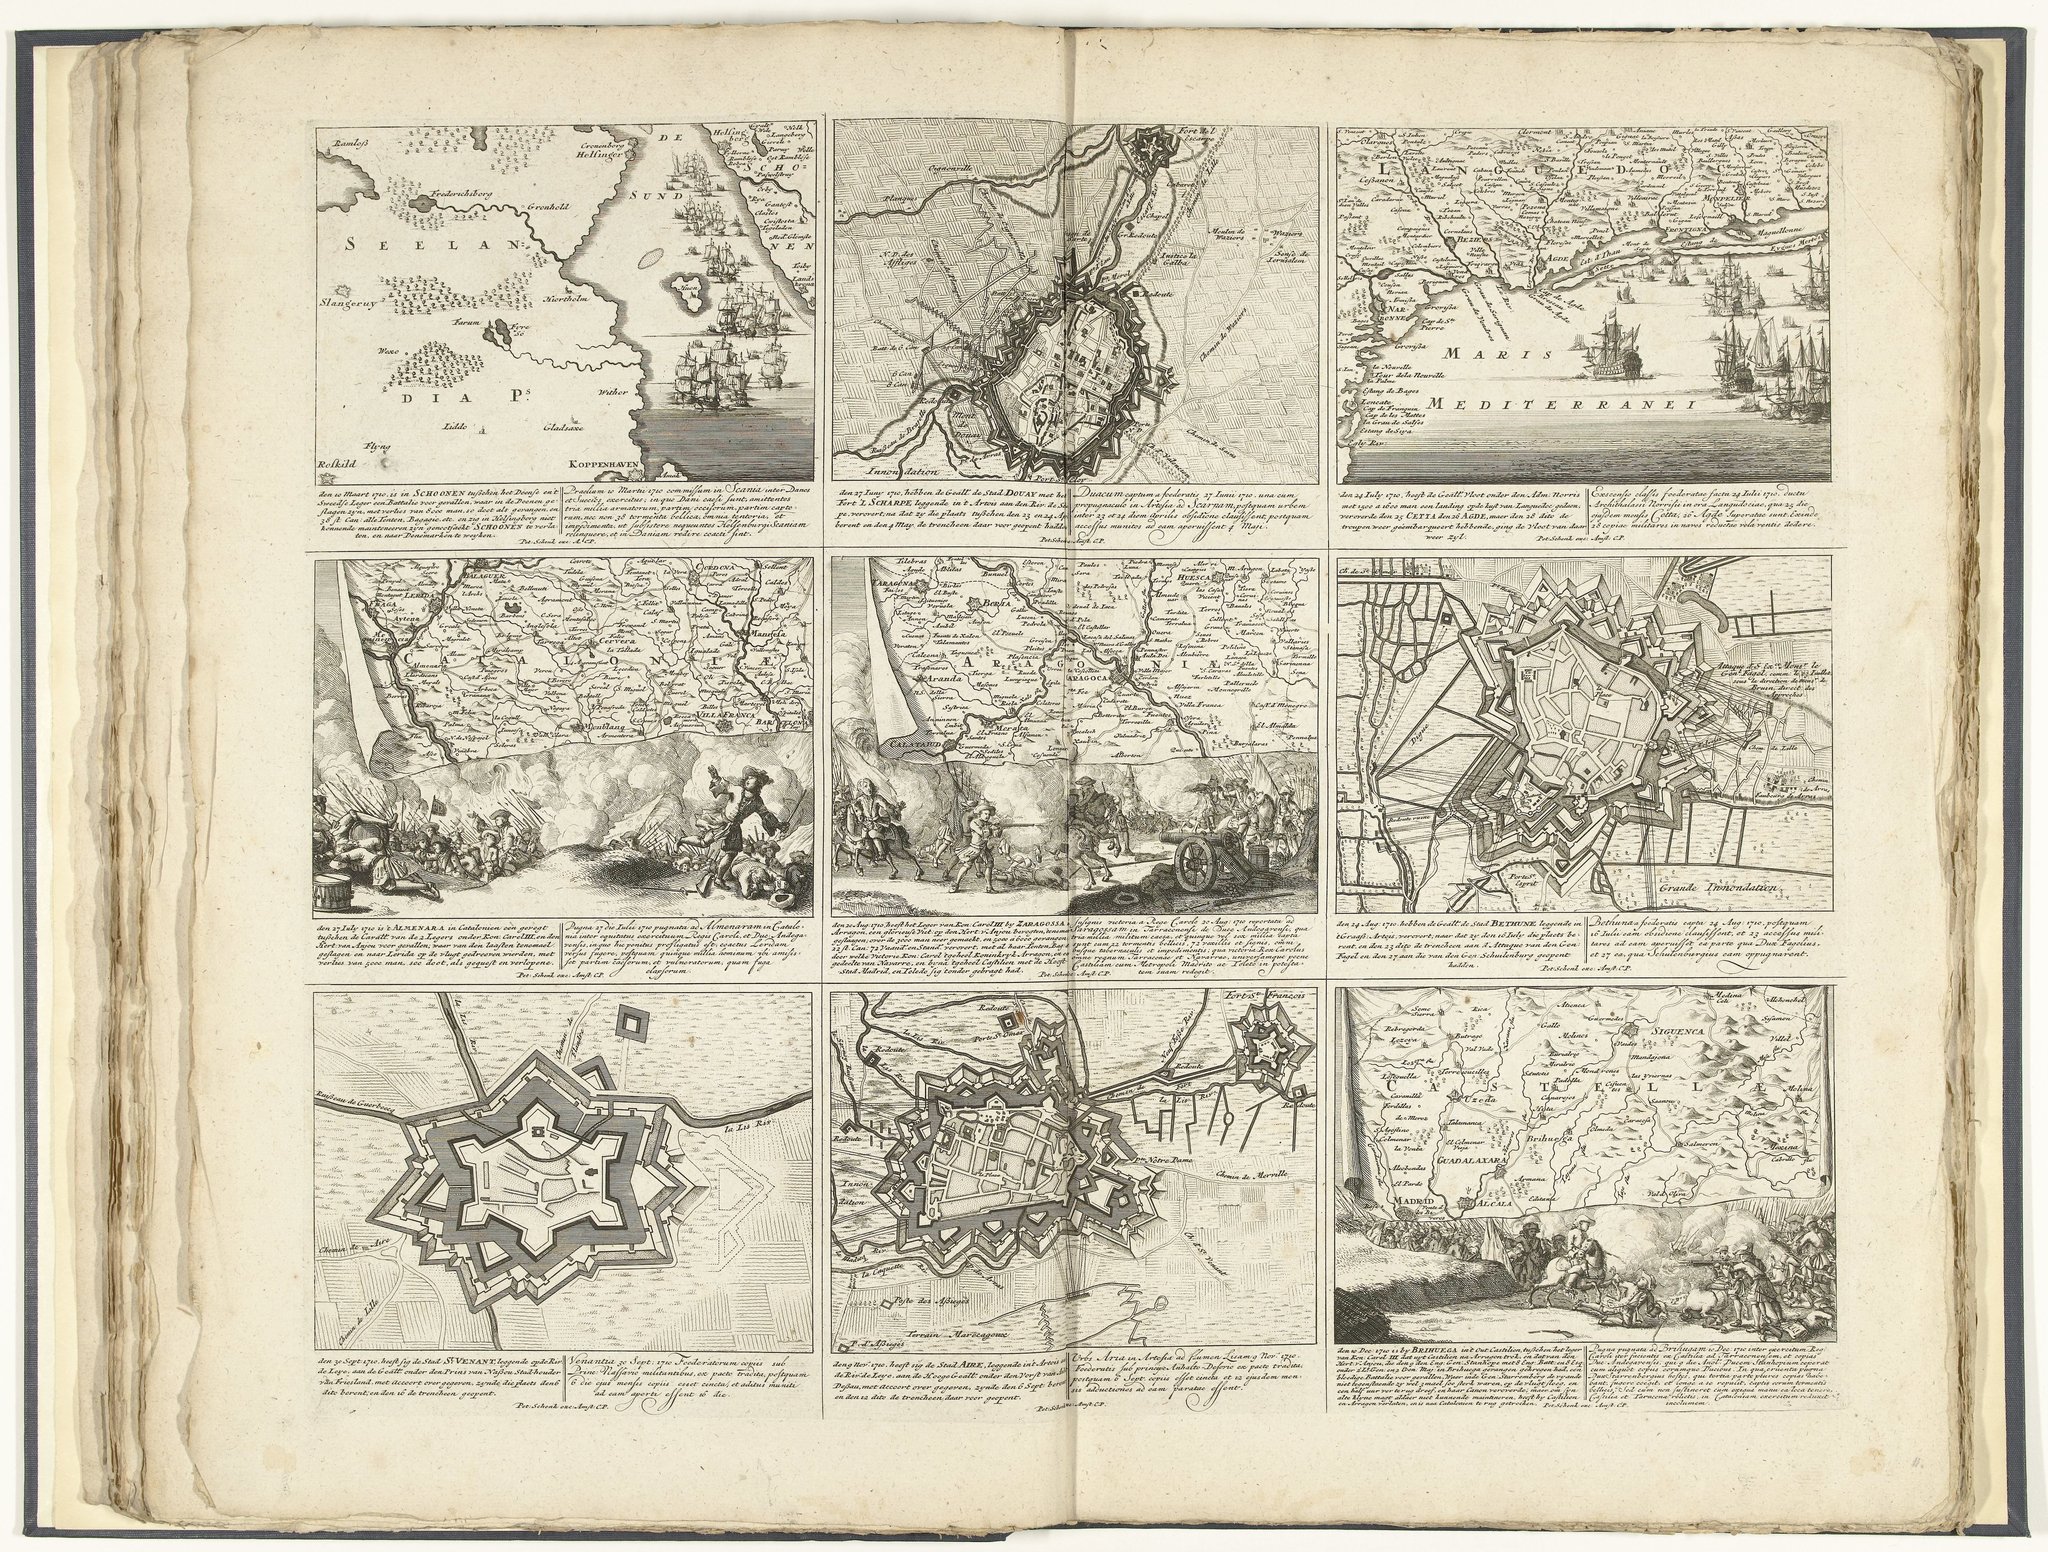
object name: map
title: Schouwtoneel van den Oorlog Beginnende met Koning Karel den tweeden Bestaande in Veldslagen, en Belegeringen, Zoo te Water als te Lande, met de voornaamste Vestingen (...)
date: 1710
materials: paper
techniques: etching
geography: amsterdam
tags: fortress, maps of separate countries or regions, maps of cities, battle (+ land forces)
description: Blad met negen voorstellingen van gebeurtenissen uit het jaar 1710 van de Spaanse Successieoorlog en van plattegronden van versterkte steden. Opschriften in de voorstelling in het Nederlands en Latijn. Plaat 10 in het prentwerk met de gebundelde reeks van 33 platen met voorstellingen (het merendeel verdeeld in 9 kleinere scènes) van gebeurtenissen uit de jaren 1700-1727 van de Spaanse Successieoorlog en de jaren daarna, kaarten en plattegronden.